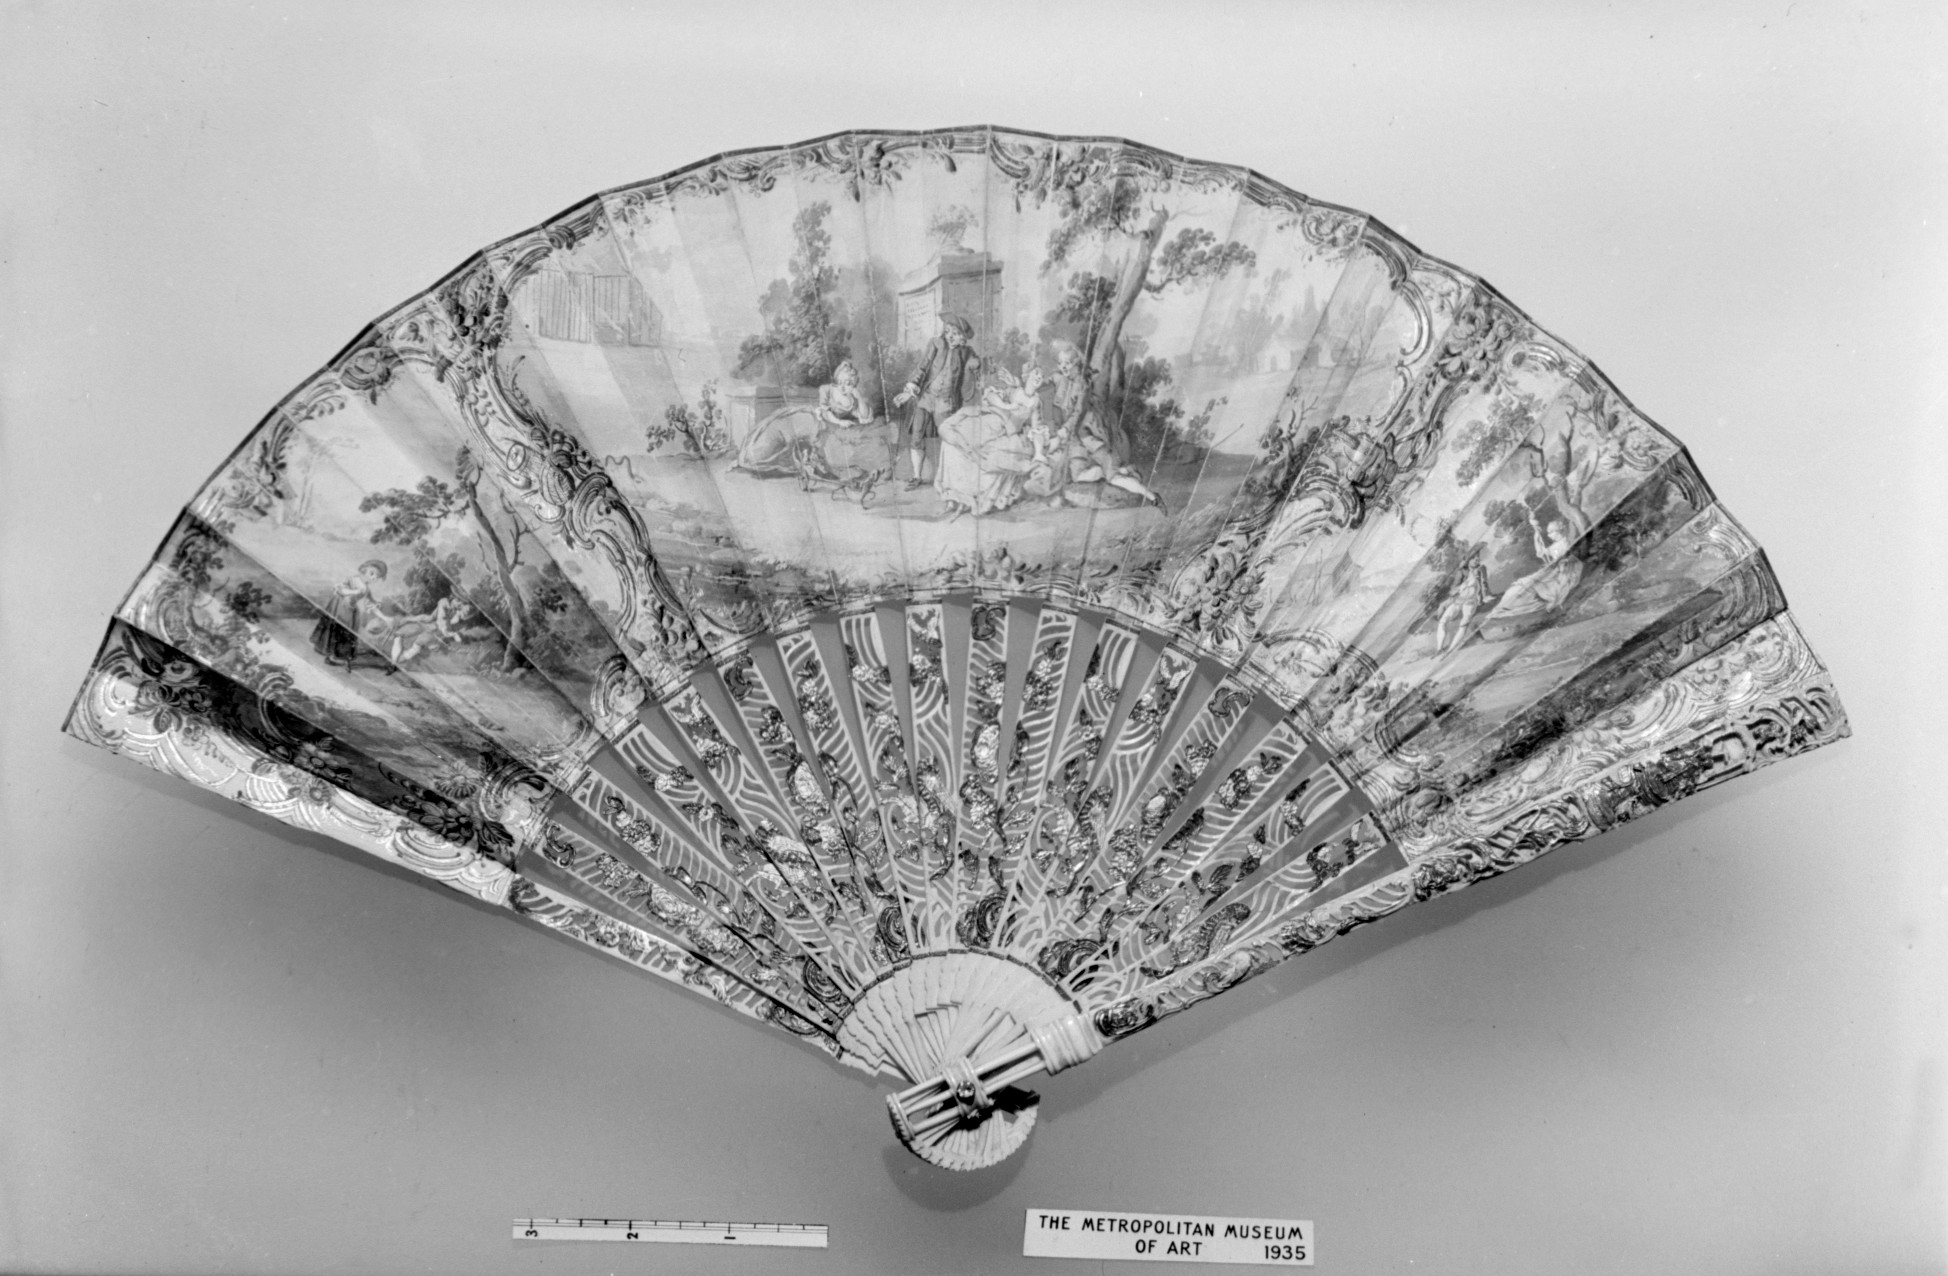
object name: fan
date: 1751-1775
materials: ivory, paint, paper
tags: men,women